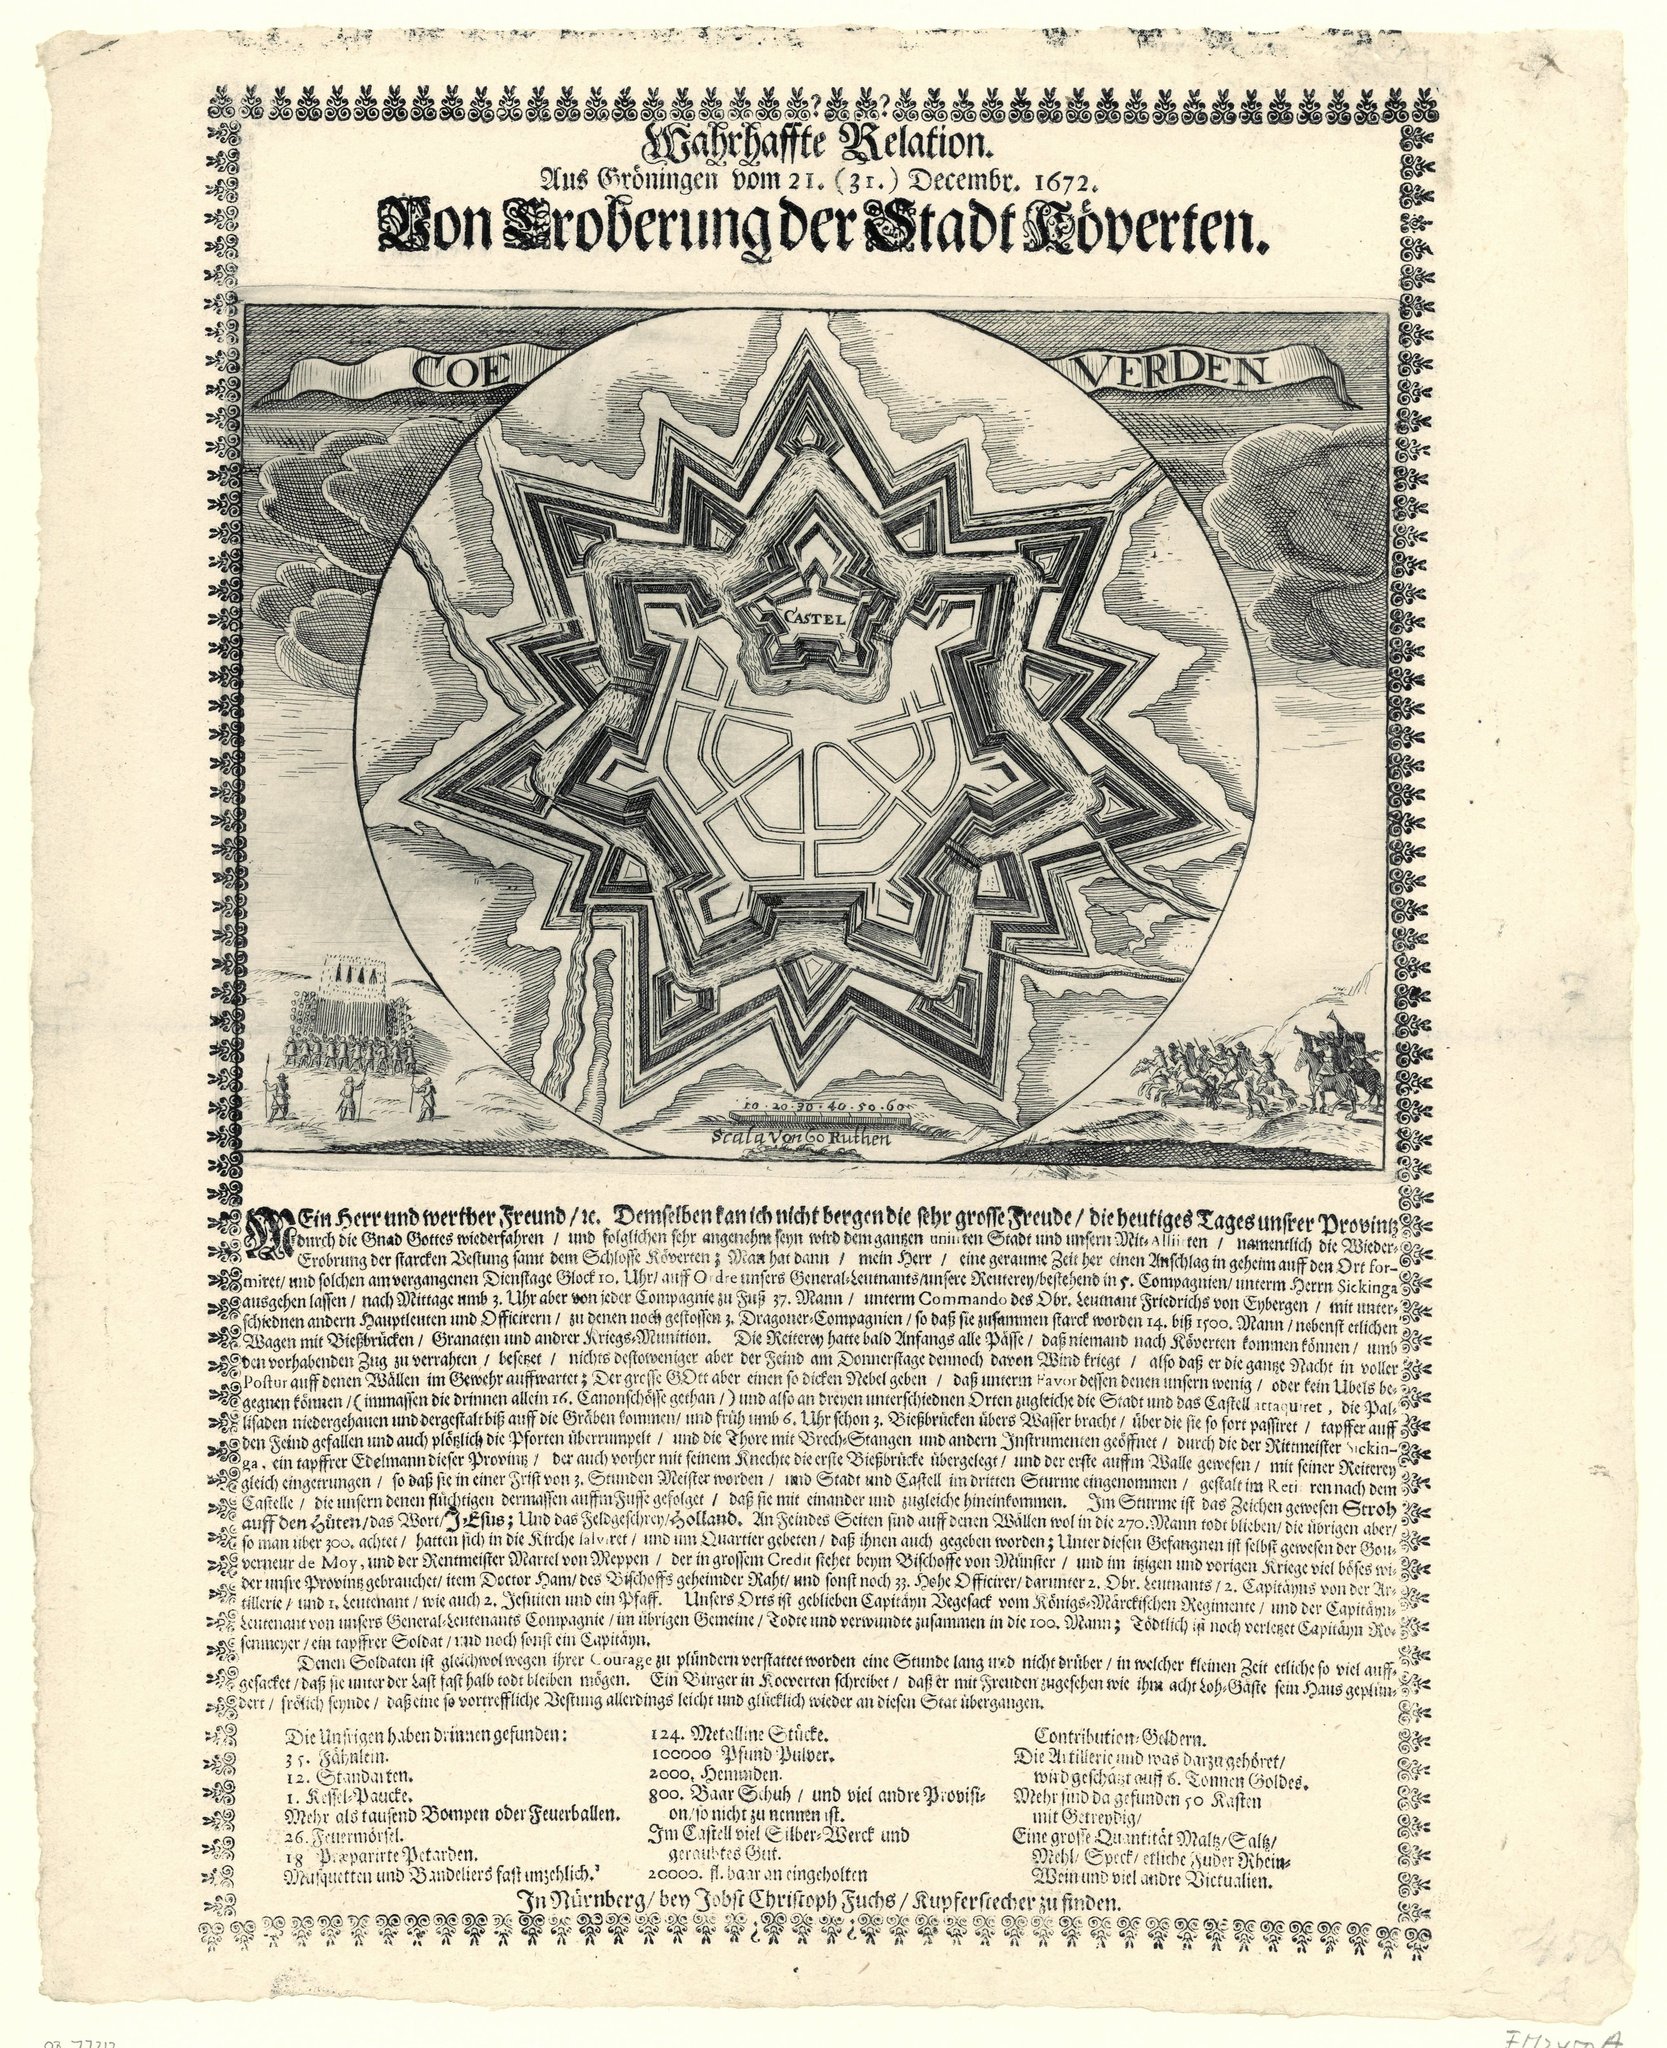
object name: print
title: Plan van de vesting van Coevorden, 1672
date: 1672-1673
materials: paper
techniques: etching, letterpress printing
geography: germany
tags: maps of cities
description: Duits blad met een plan van de vesting van Coevorden en een beschrijving van de verovering van de stad op 30 december 1672 door de troepen van Karl Rabenhaupt op de legers van de bisschop van Munster. Het plan is voorgesteld in een cirkel tegen een landschap met wolkenlucht en enkele legers. De voorstelling is gekopieerd naar de prent uitgegeven door Justus Danckerts (FMH 2450). Onder de voorstelling een beschrijving van het verloop van de strijd en een lijst van buitgemaakte wapens en voorraden, in het Duits.